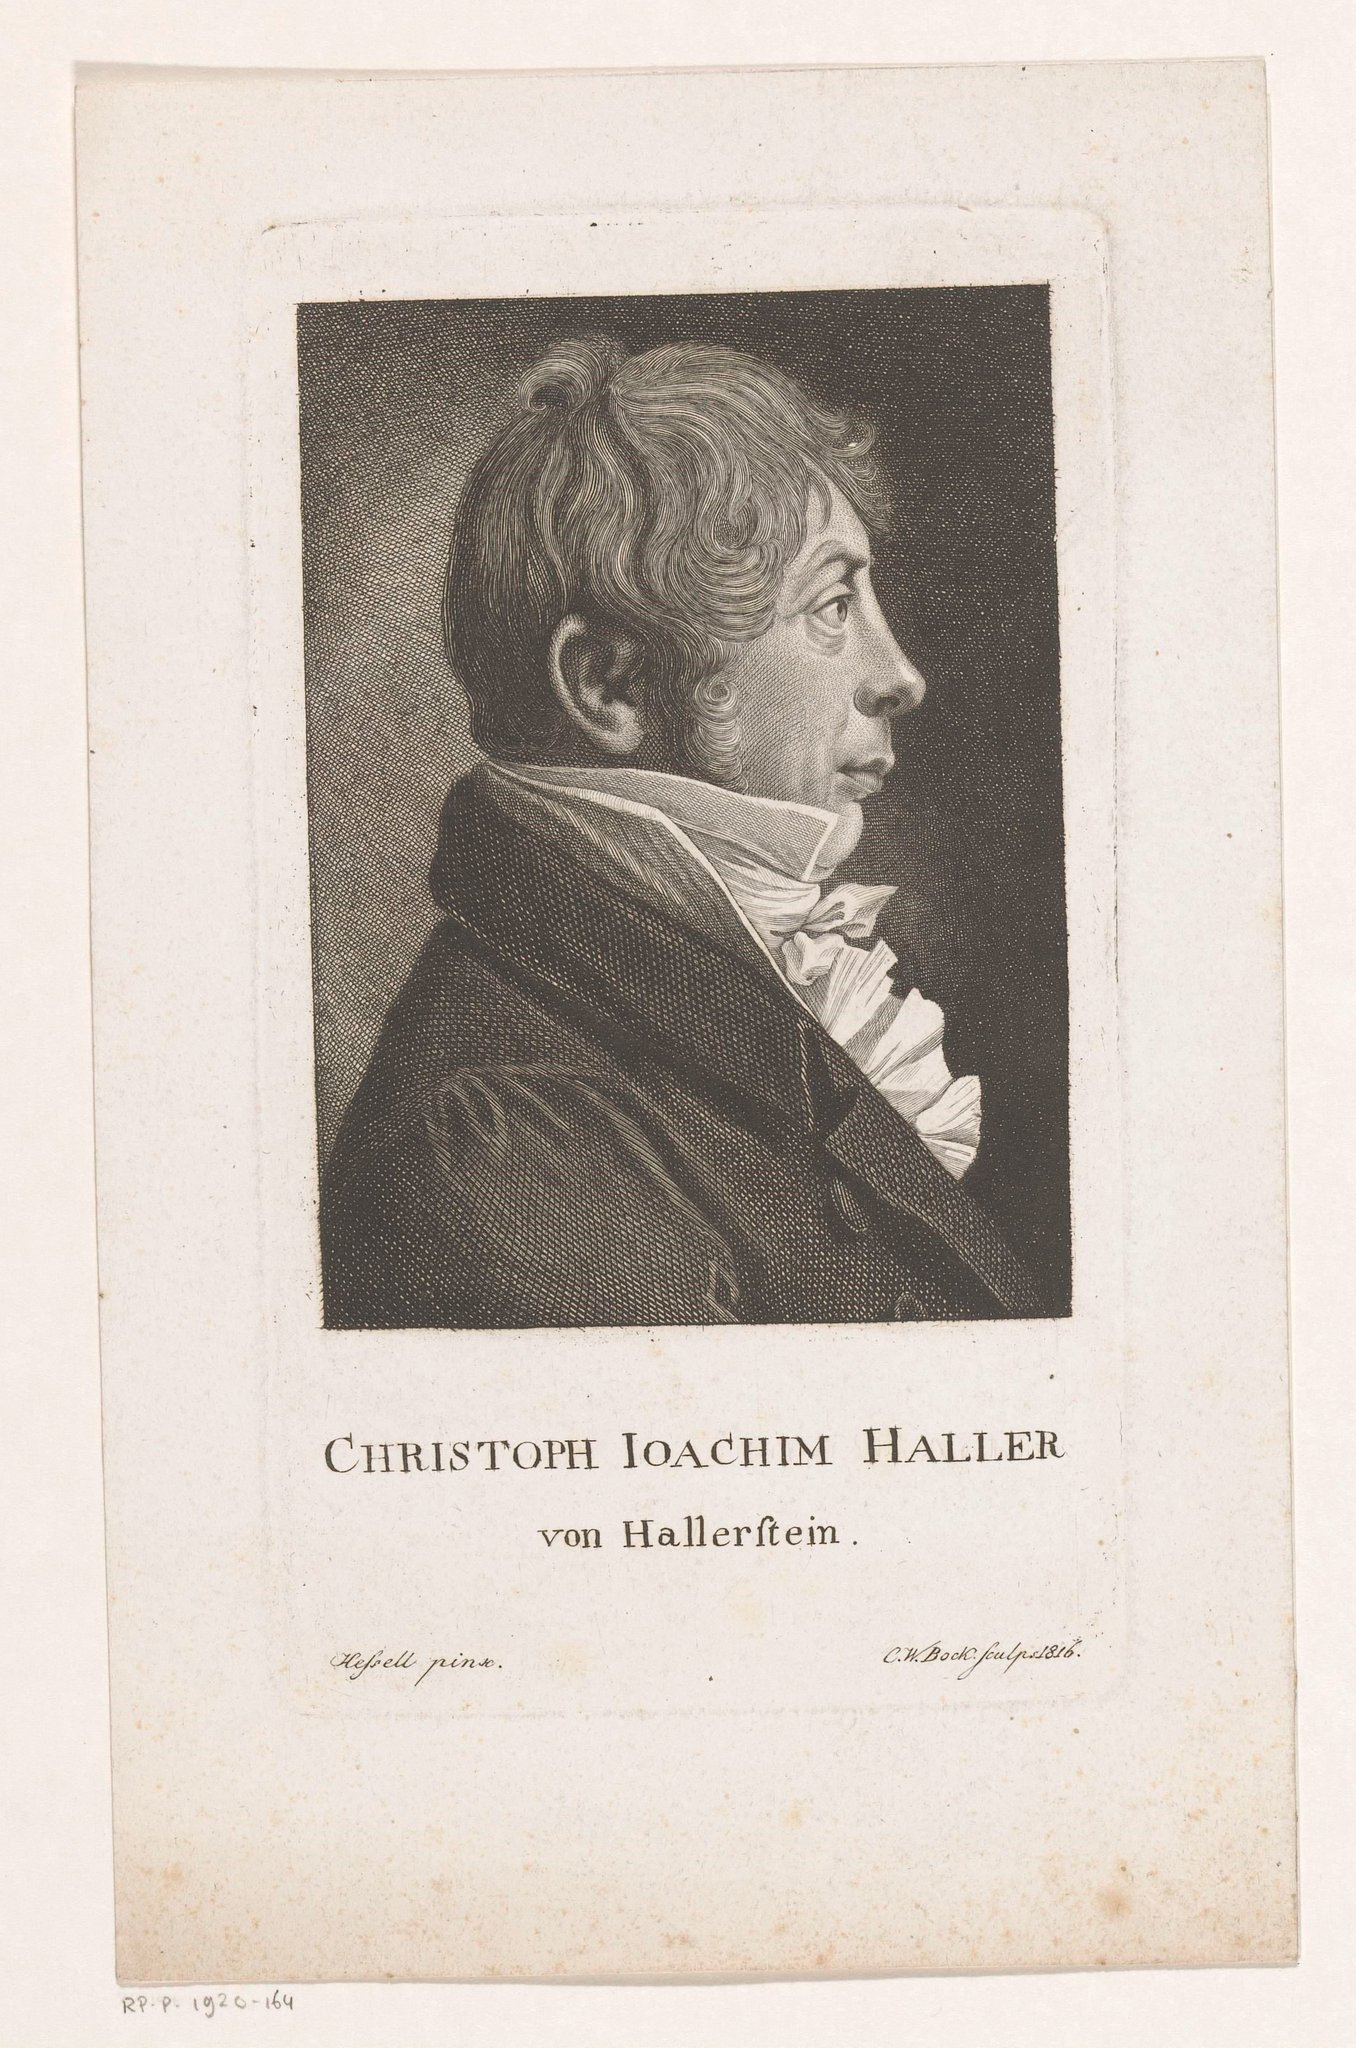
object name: print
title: Portret van Christoph Hans Joachim, Freiherr Haller von Hallerstein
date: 1816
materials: paper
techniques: engraving, etching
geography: nuremberg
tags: historical persons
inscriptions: collector's mark: Lugt 2228